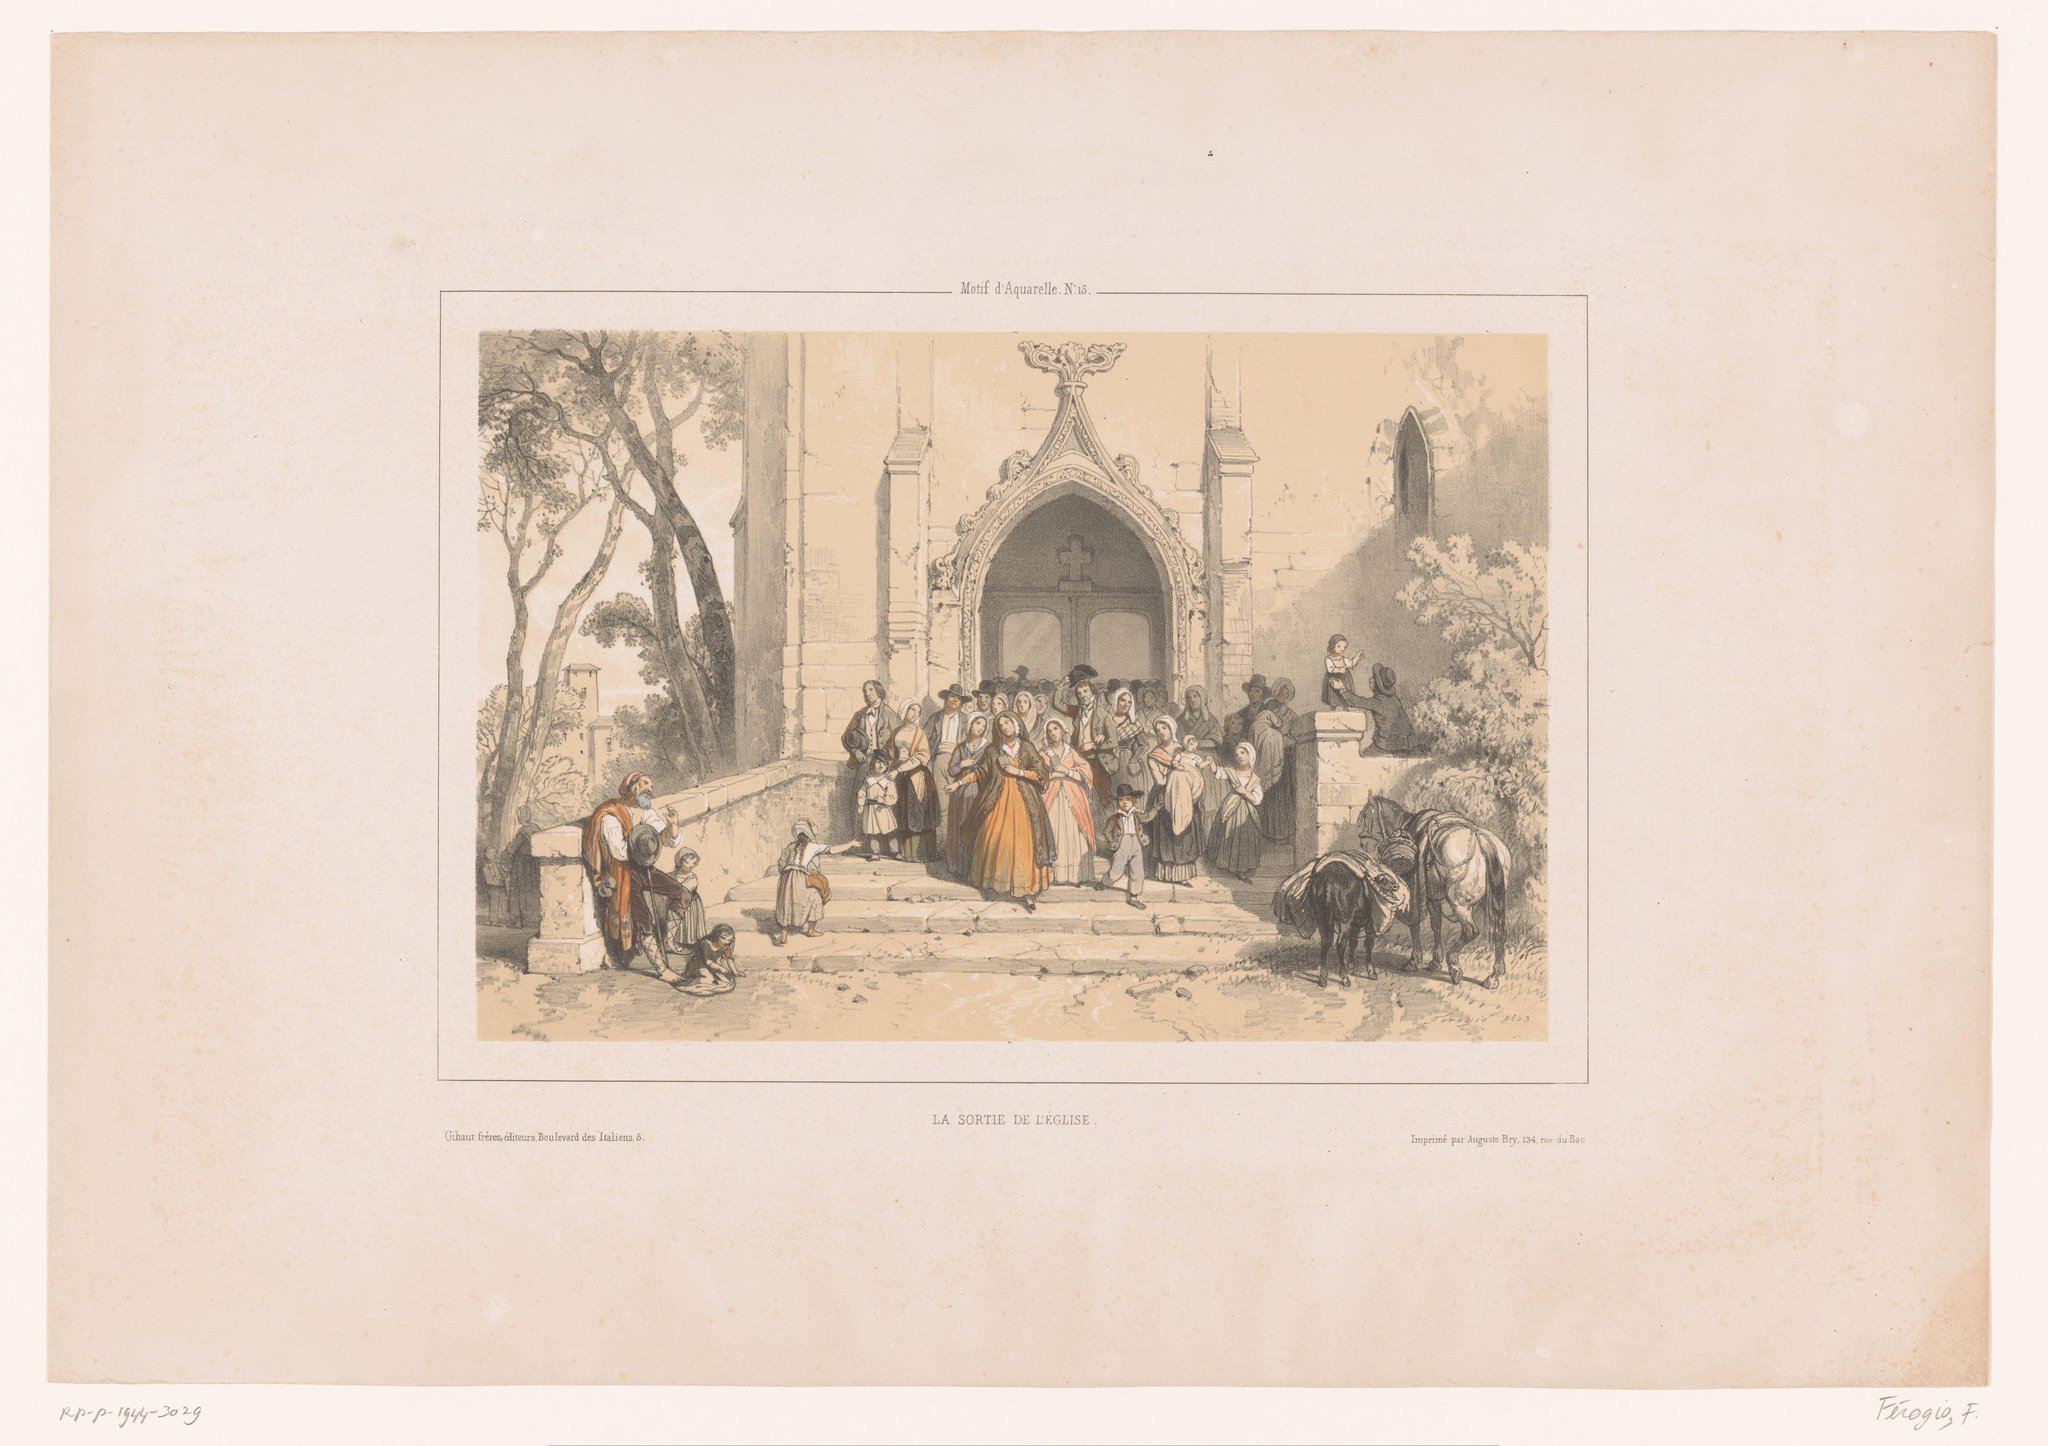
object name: print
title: Motifs d'Aquarelle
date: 1842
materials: paper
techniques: hand coloring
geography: paris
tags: leaving the church after service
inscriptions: collector's mark: Lugt 2228a